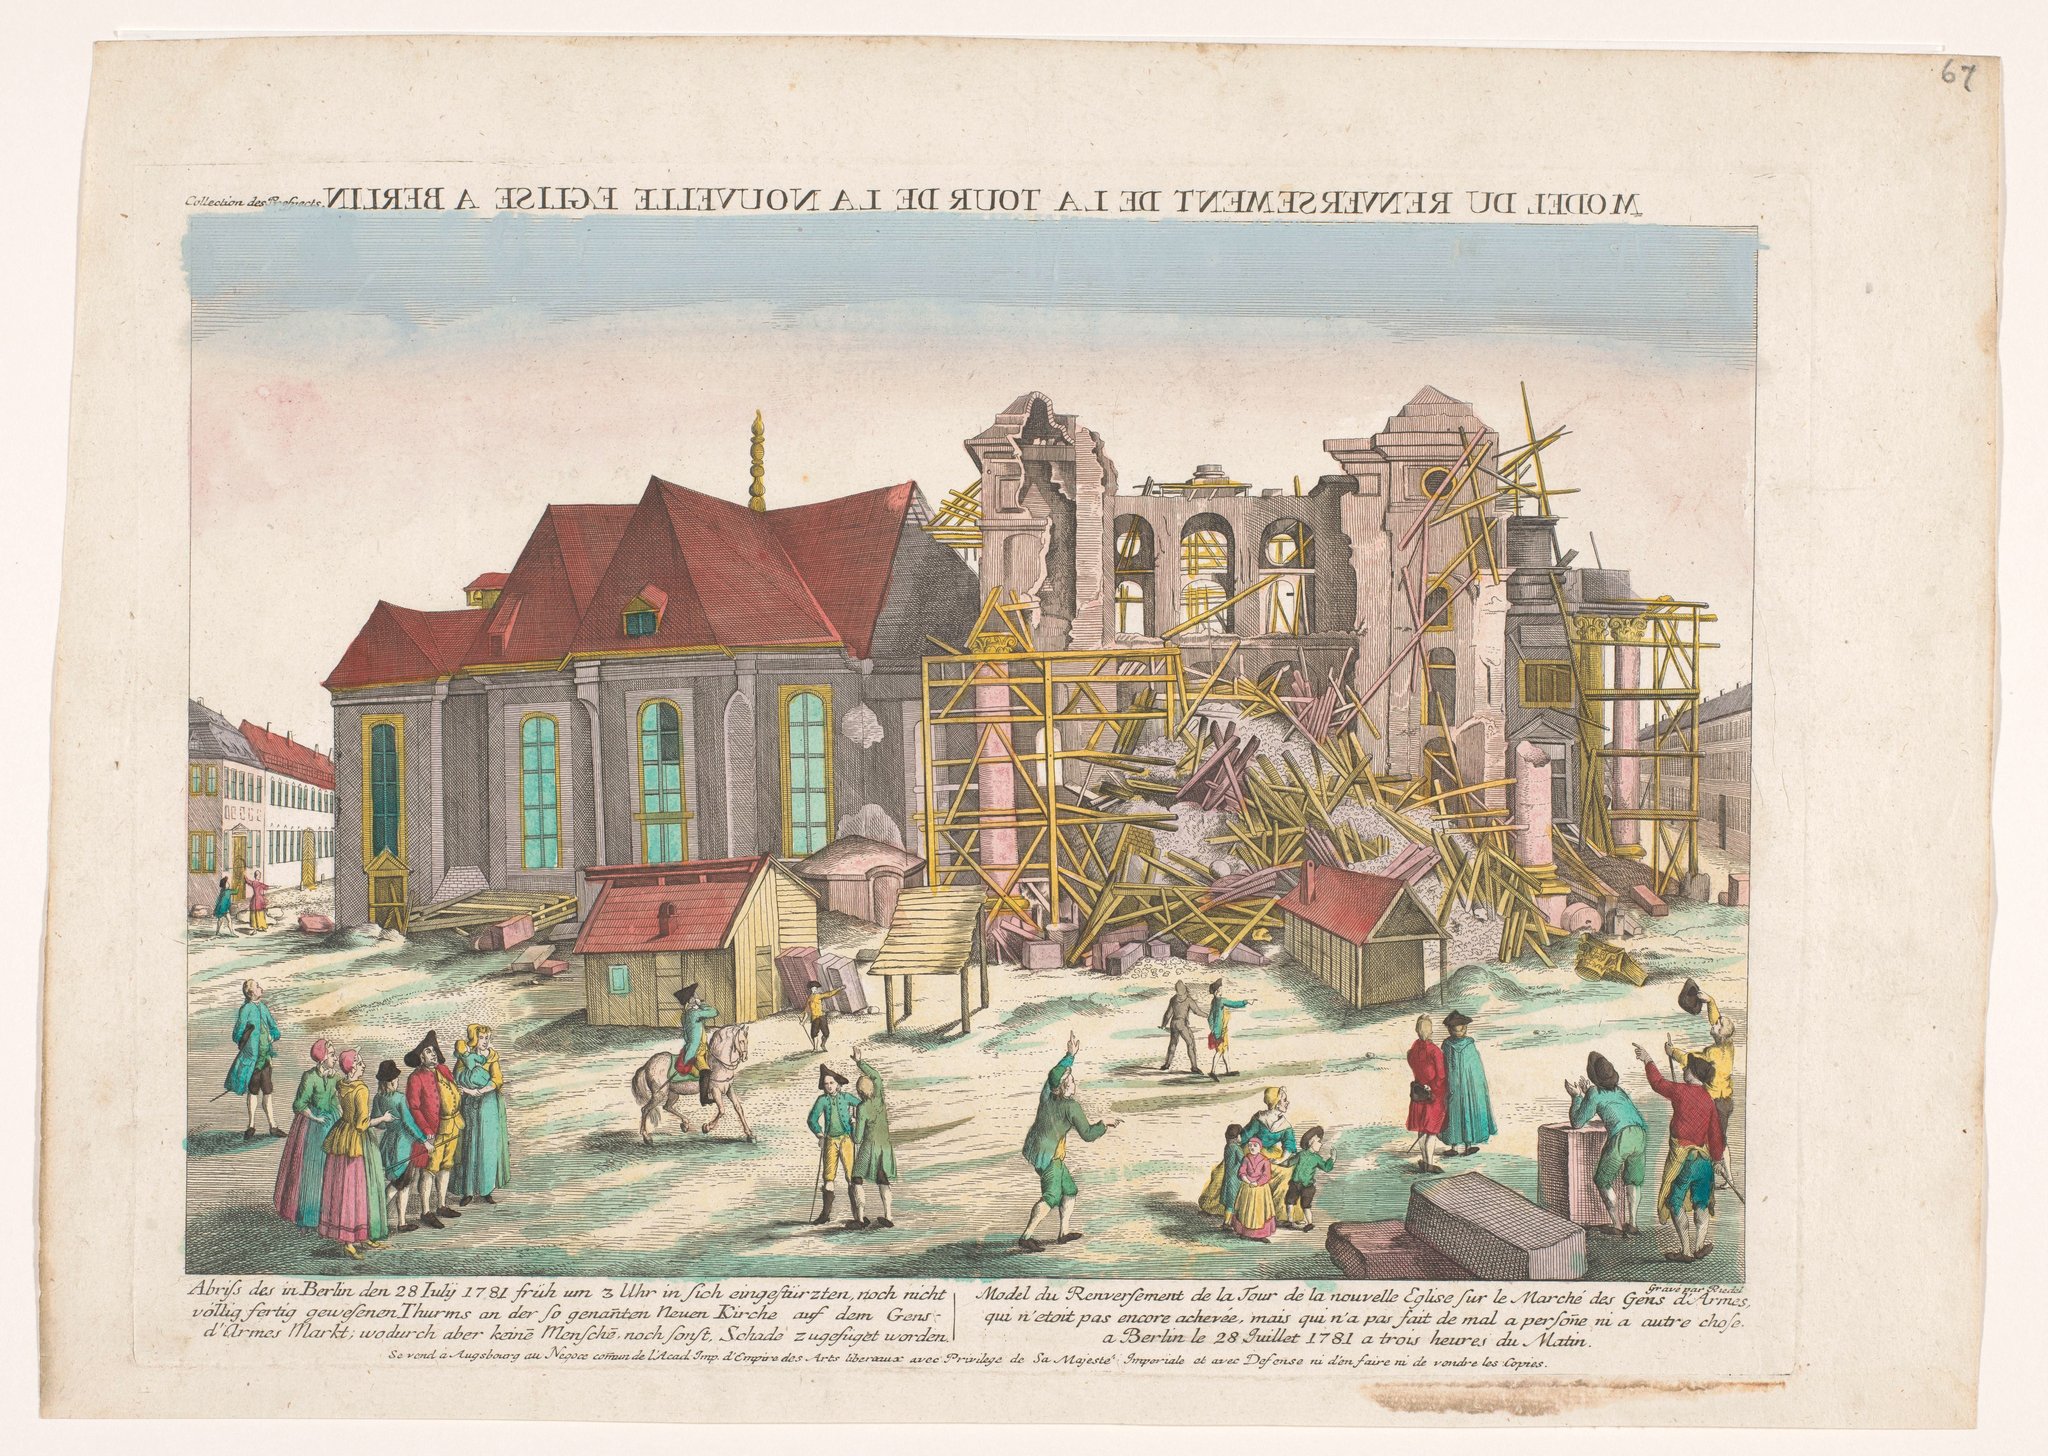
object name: print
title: Gezicht op het instorten van de nieuwe toren van de Deutscher Dom te Berlijn op 28 juli 1781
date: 1755-1779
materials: paper, watercolor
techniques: brush, etching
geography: germany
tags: church (exterior), collapsing building